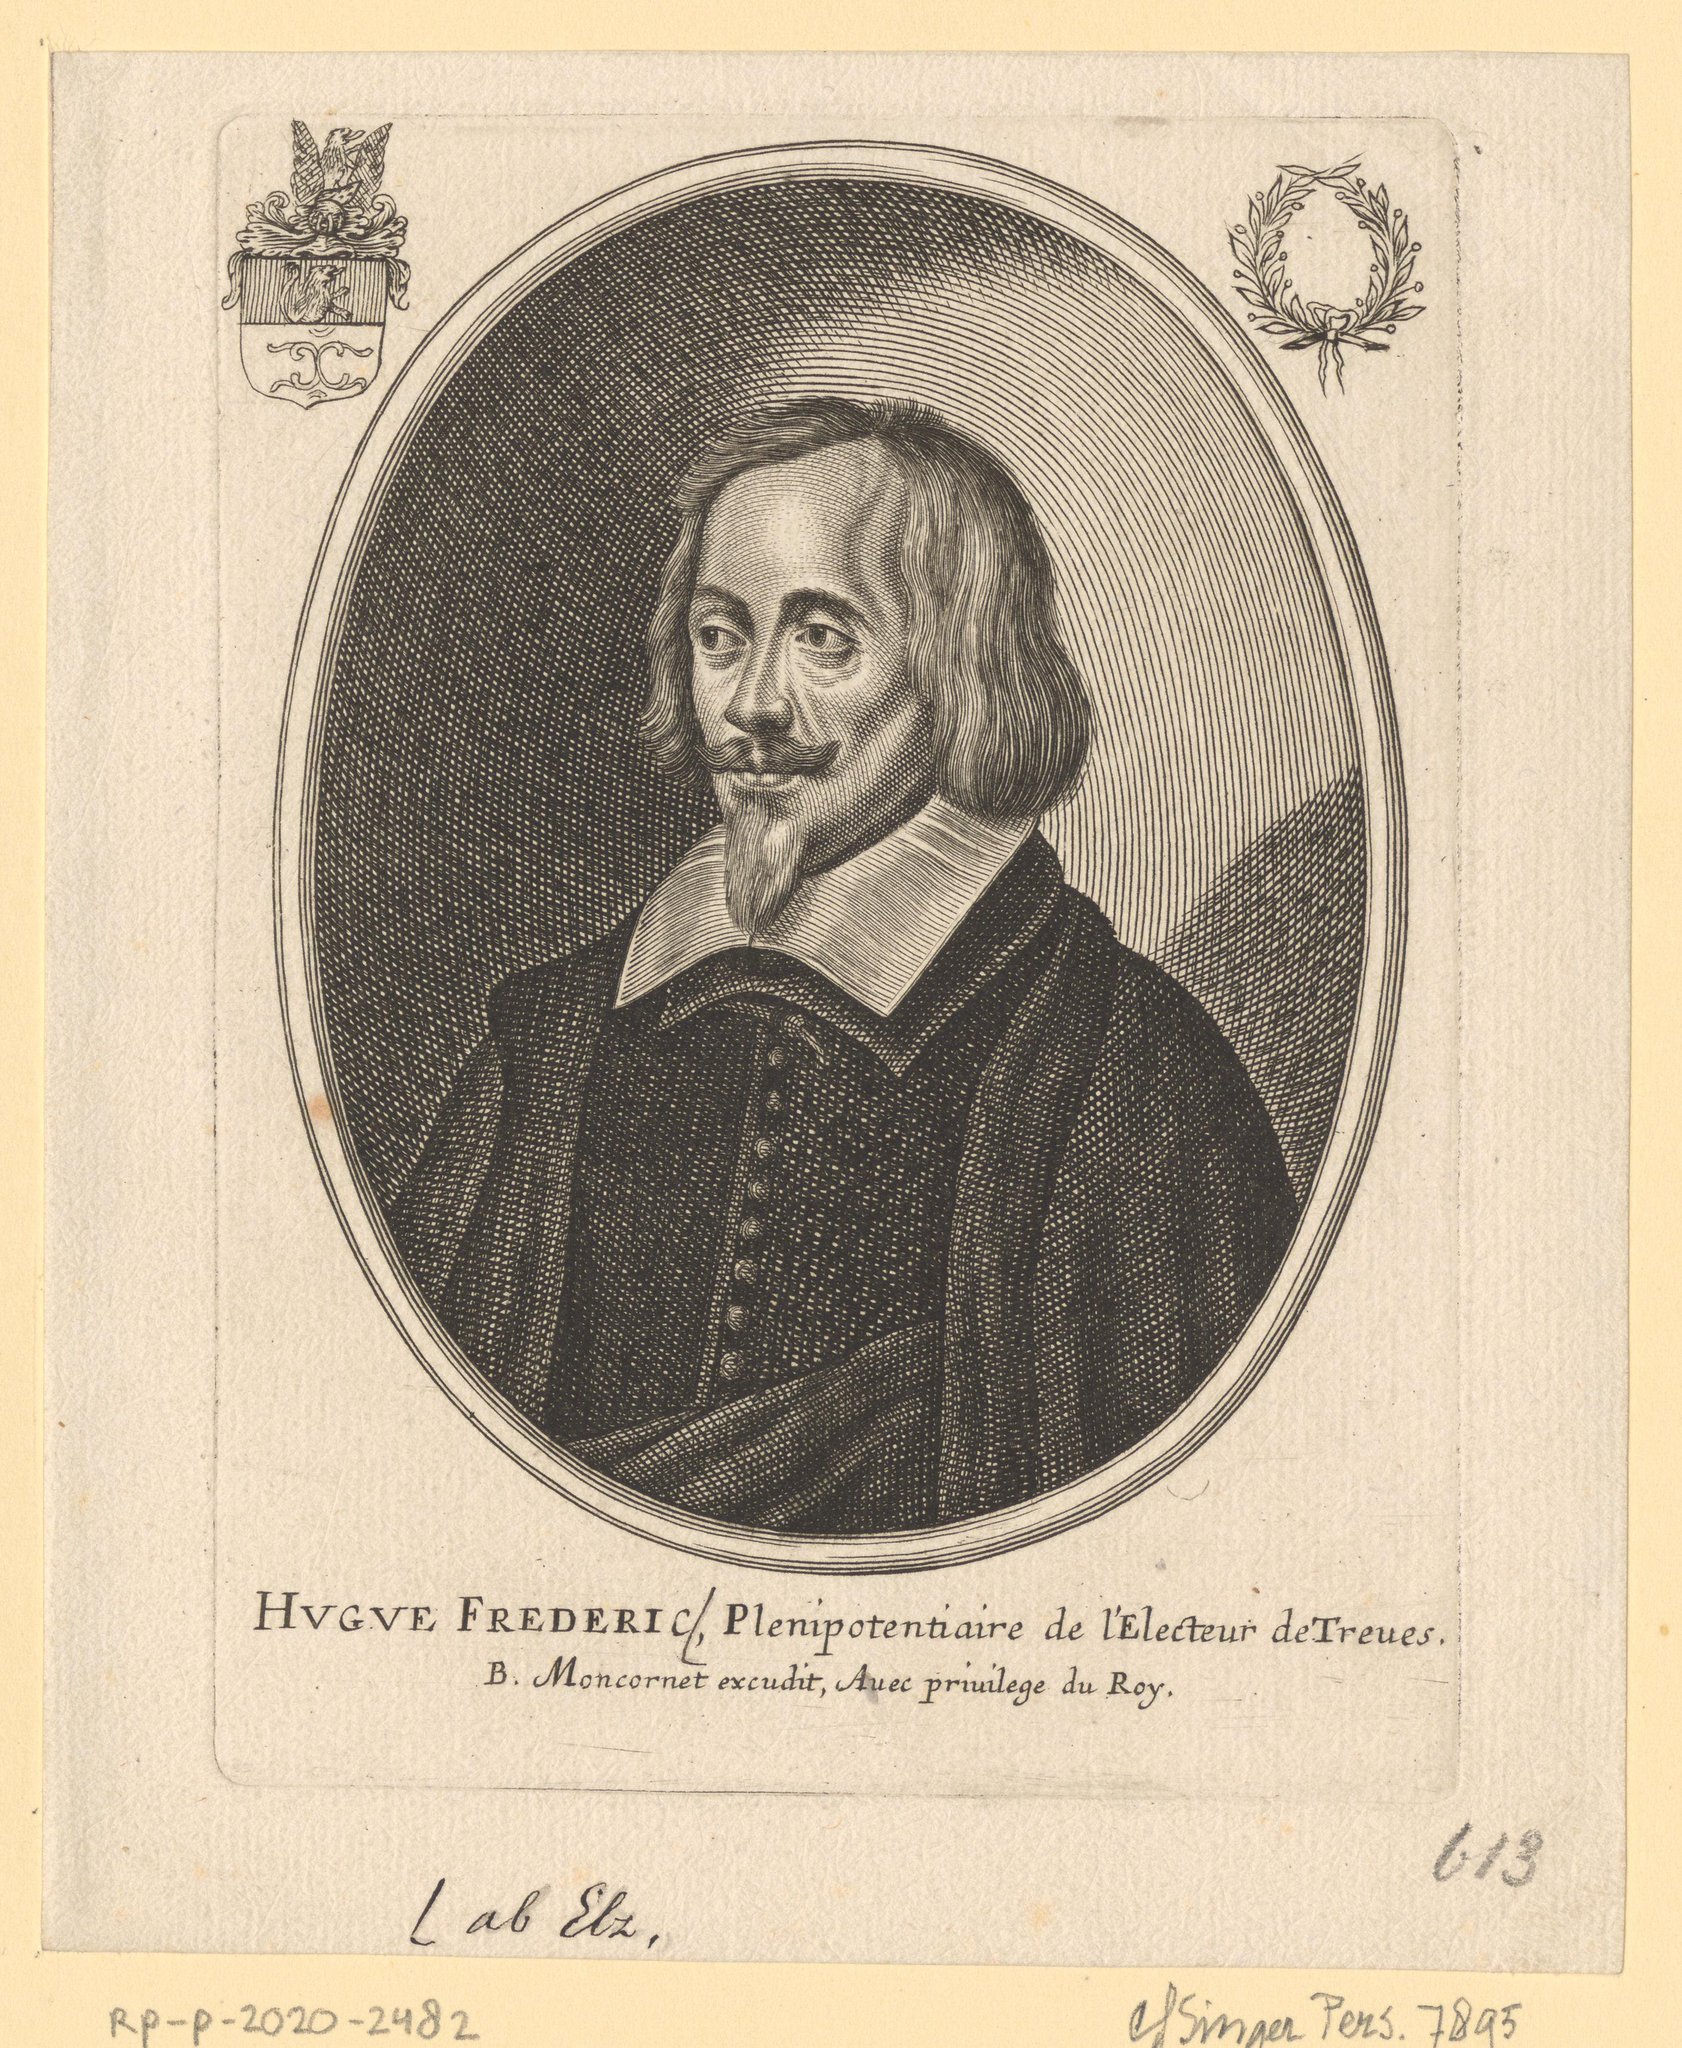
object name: print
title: Portretten van de ambassadeurs van de Vrede van Westfalen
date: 1648-1668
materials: paper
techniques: engraving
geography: paris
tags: historical persons, armorial bearing, heraldry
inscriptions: inscription: ‘L ab Elz.’